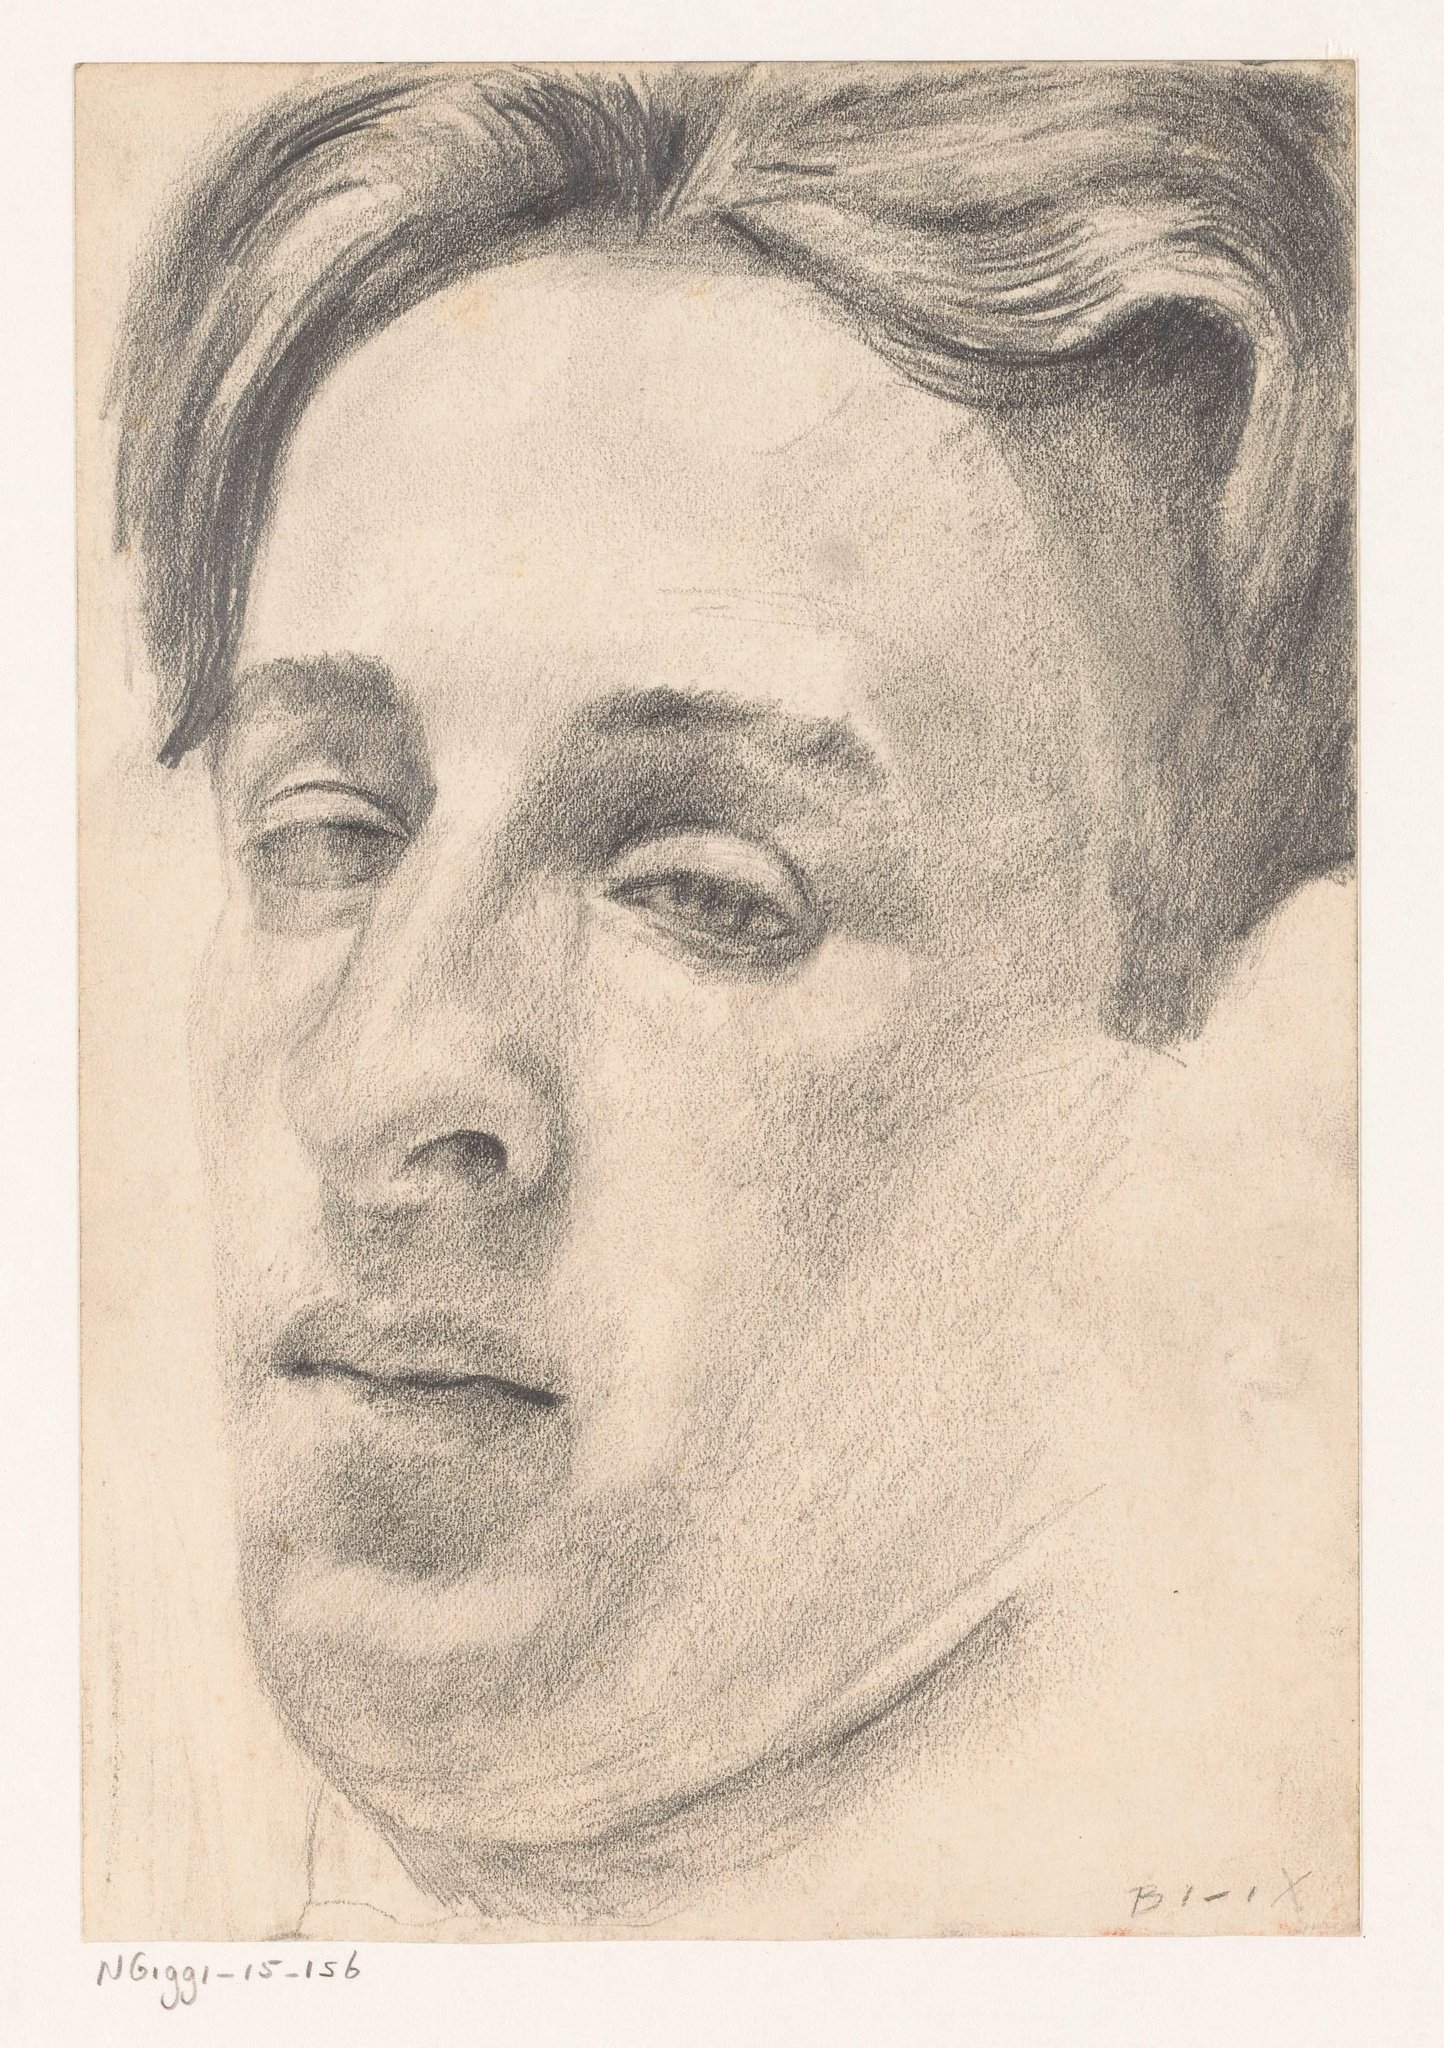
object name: drawing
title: Zelfportretten van Cor van Teeseling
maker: cor van teeseling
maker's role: draughtsman, sculptor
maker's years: 1915-1942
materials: chalk, paper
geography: weteringschans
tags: amsterdam, draughtsman, sculptor, cor van teeseling, historical persons, prisoner in cell or locked place, portrait, self-portrait of draughtsman, netherlands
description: Zelfportret van Cor van Teeseling: B-1-1, driekwart naar links gewend.